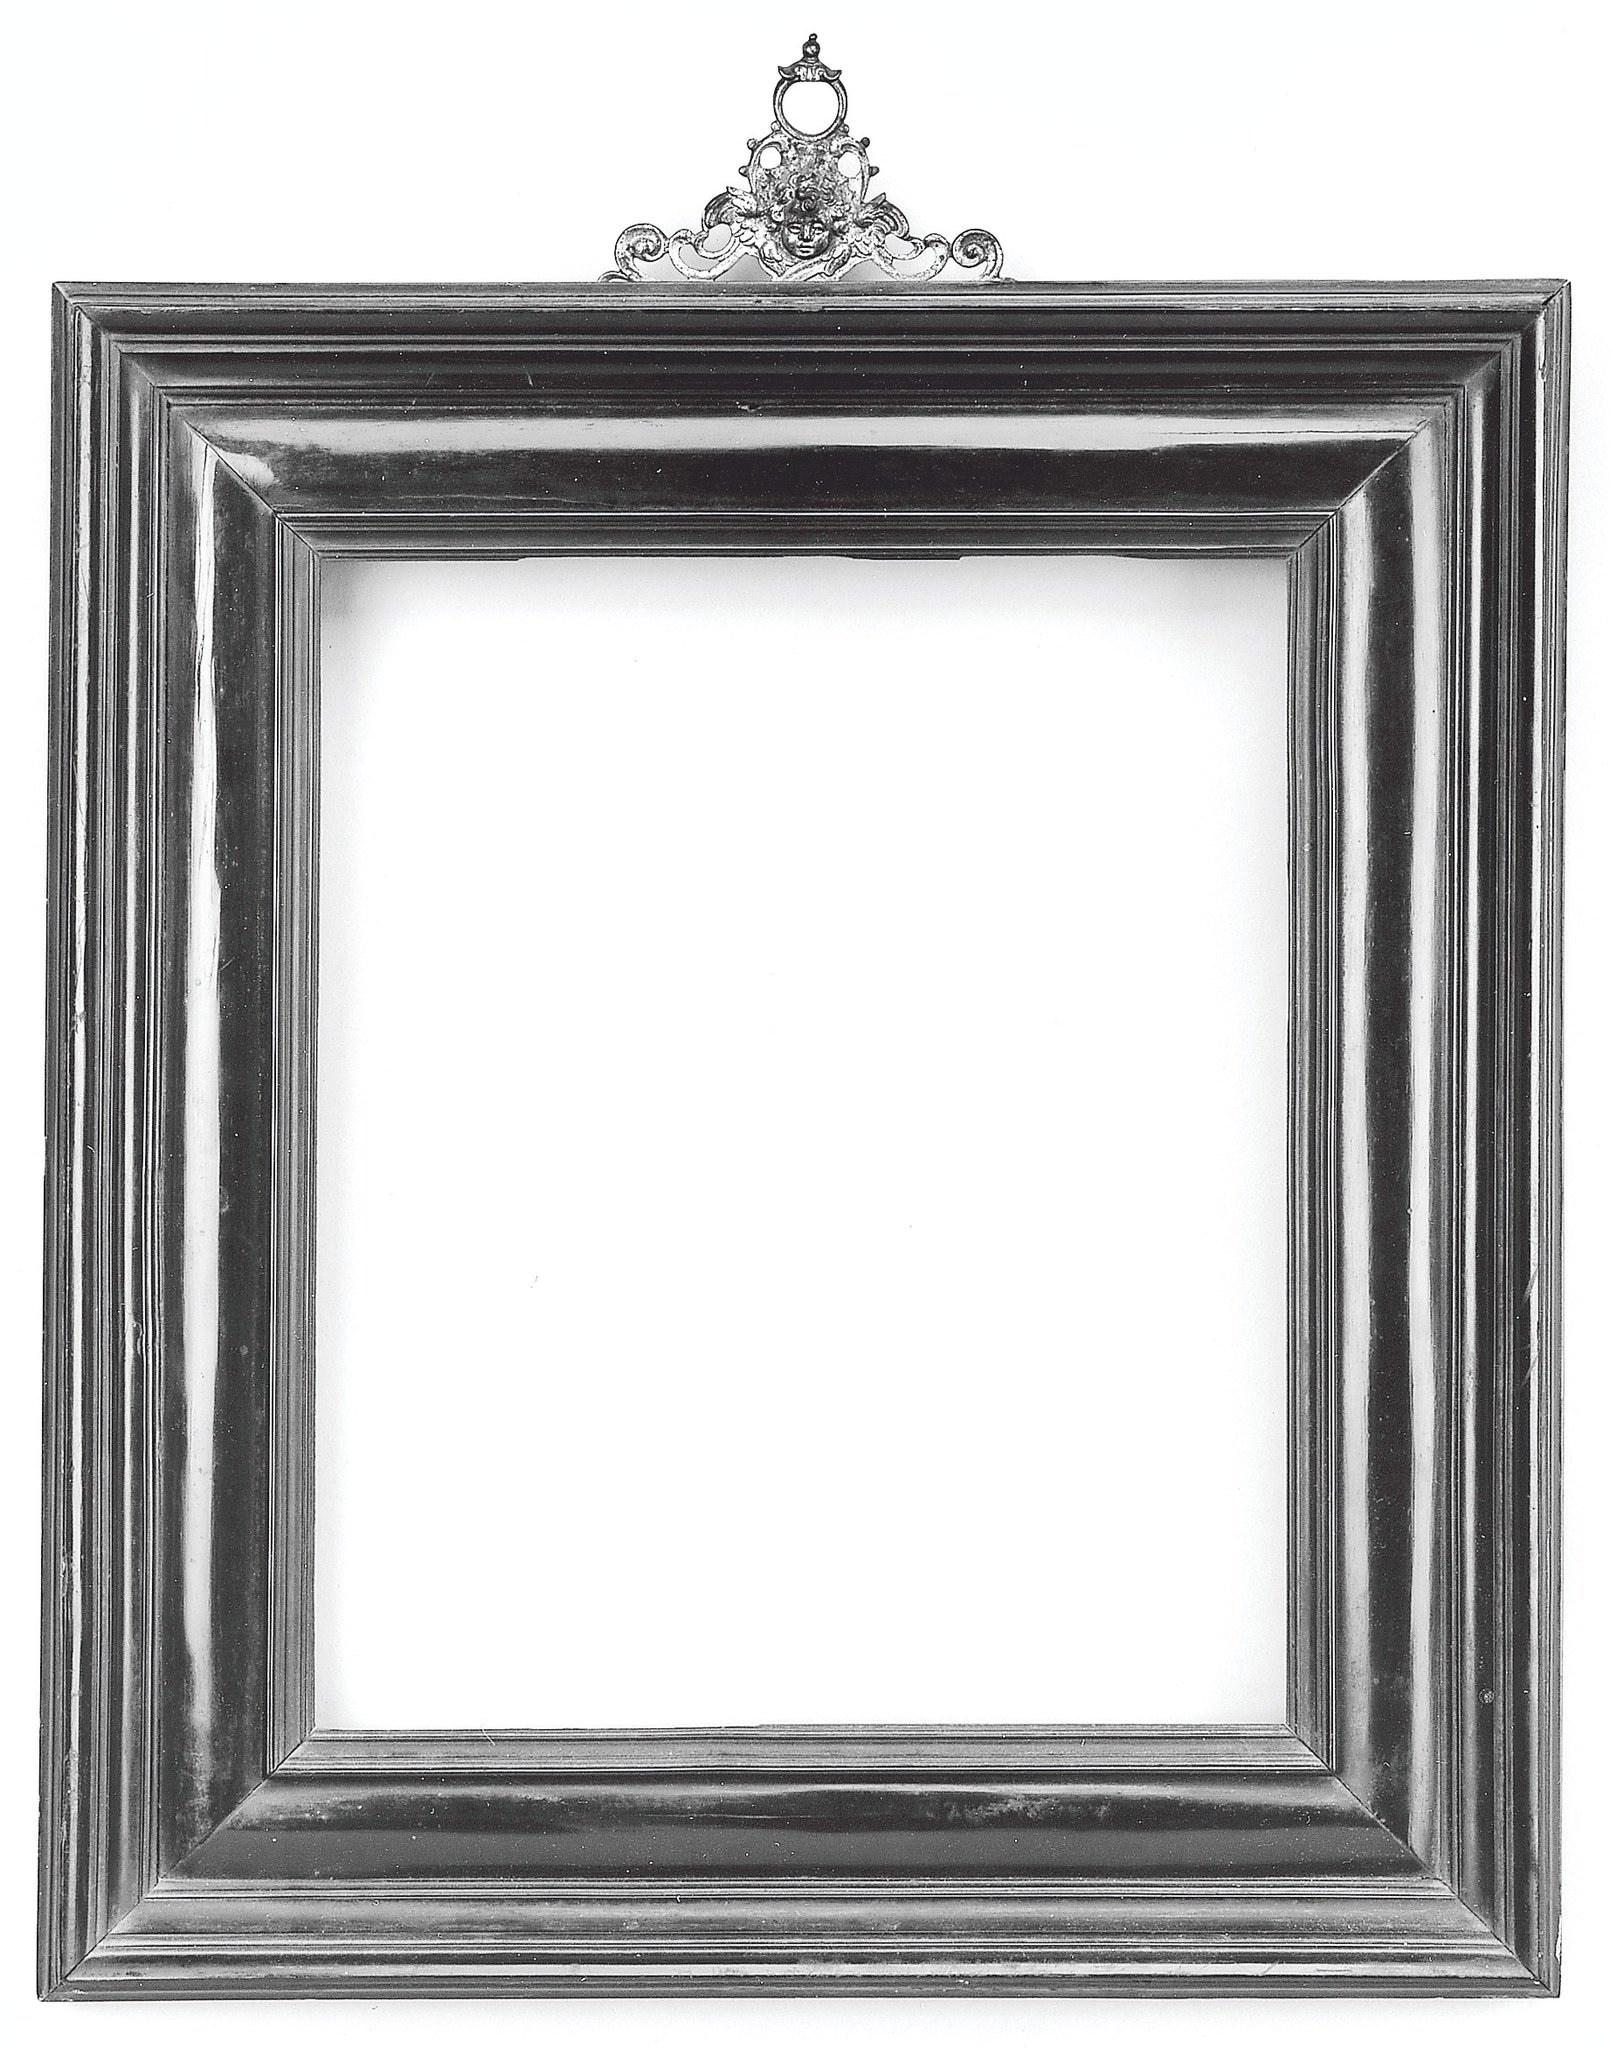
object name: frame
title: Cassetta frame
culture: italian, veneto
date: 1867-1900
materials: wood